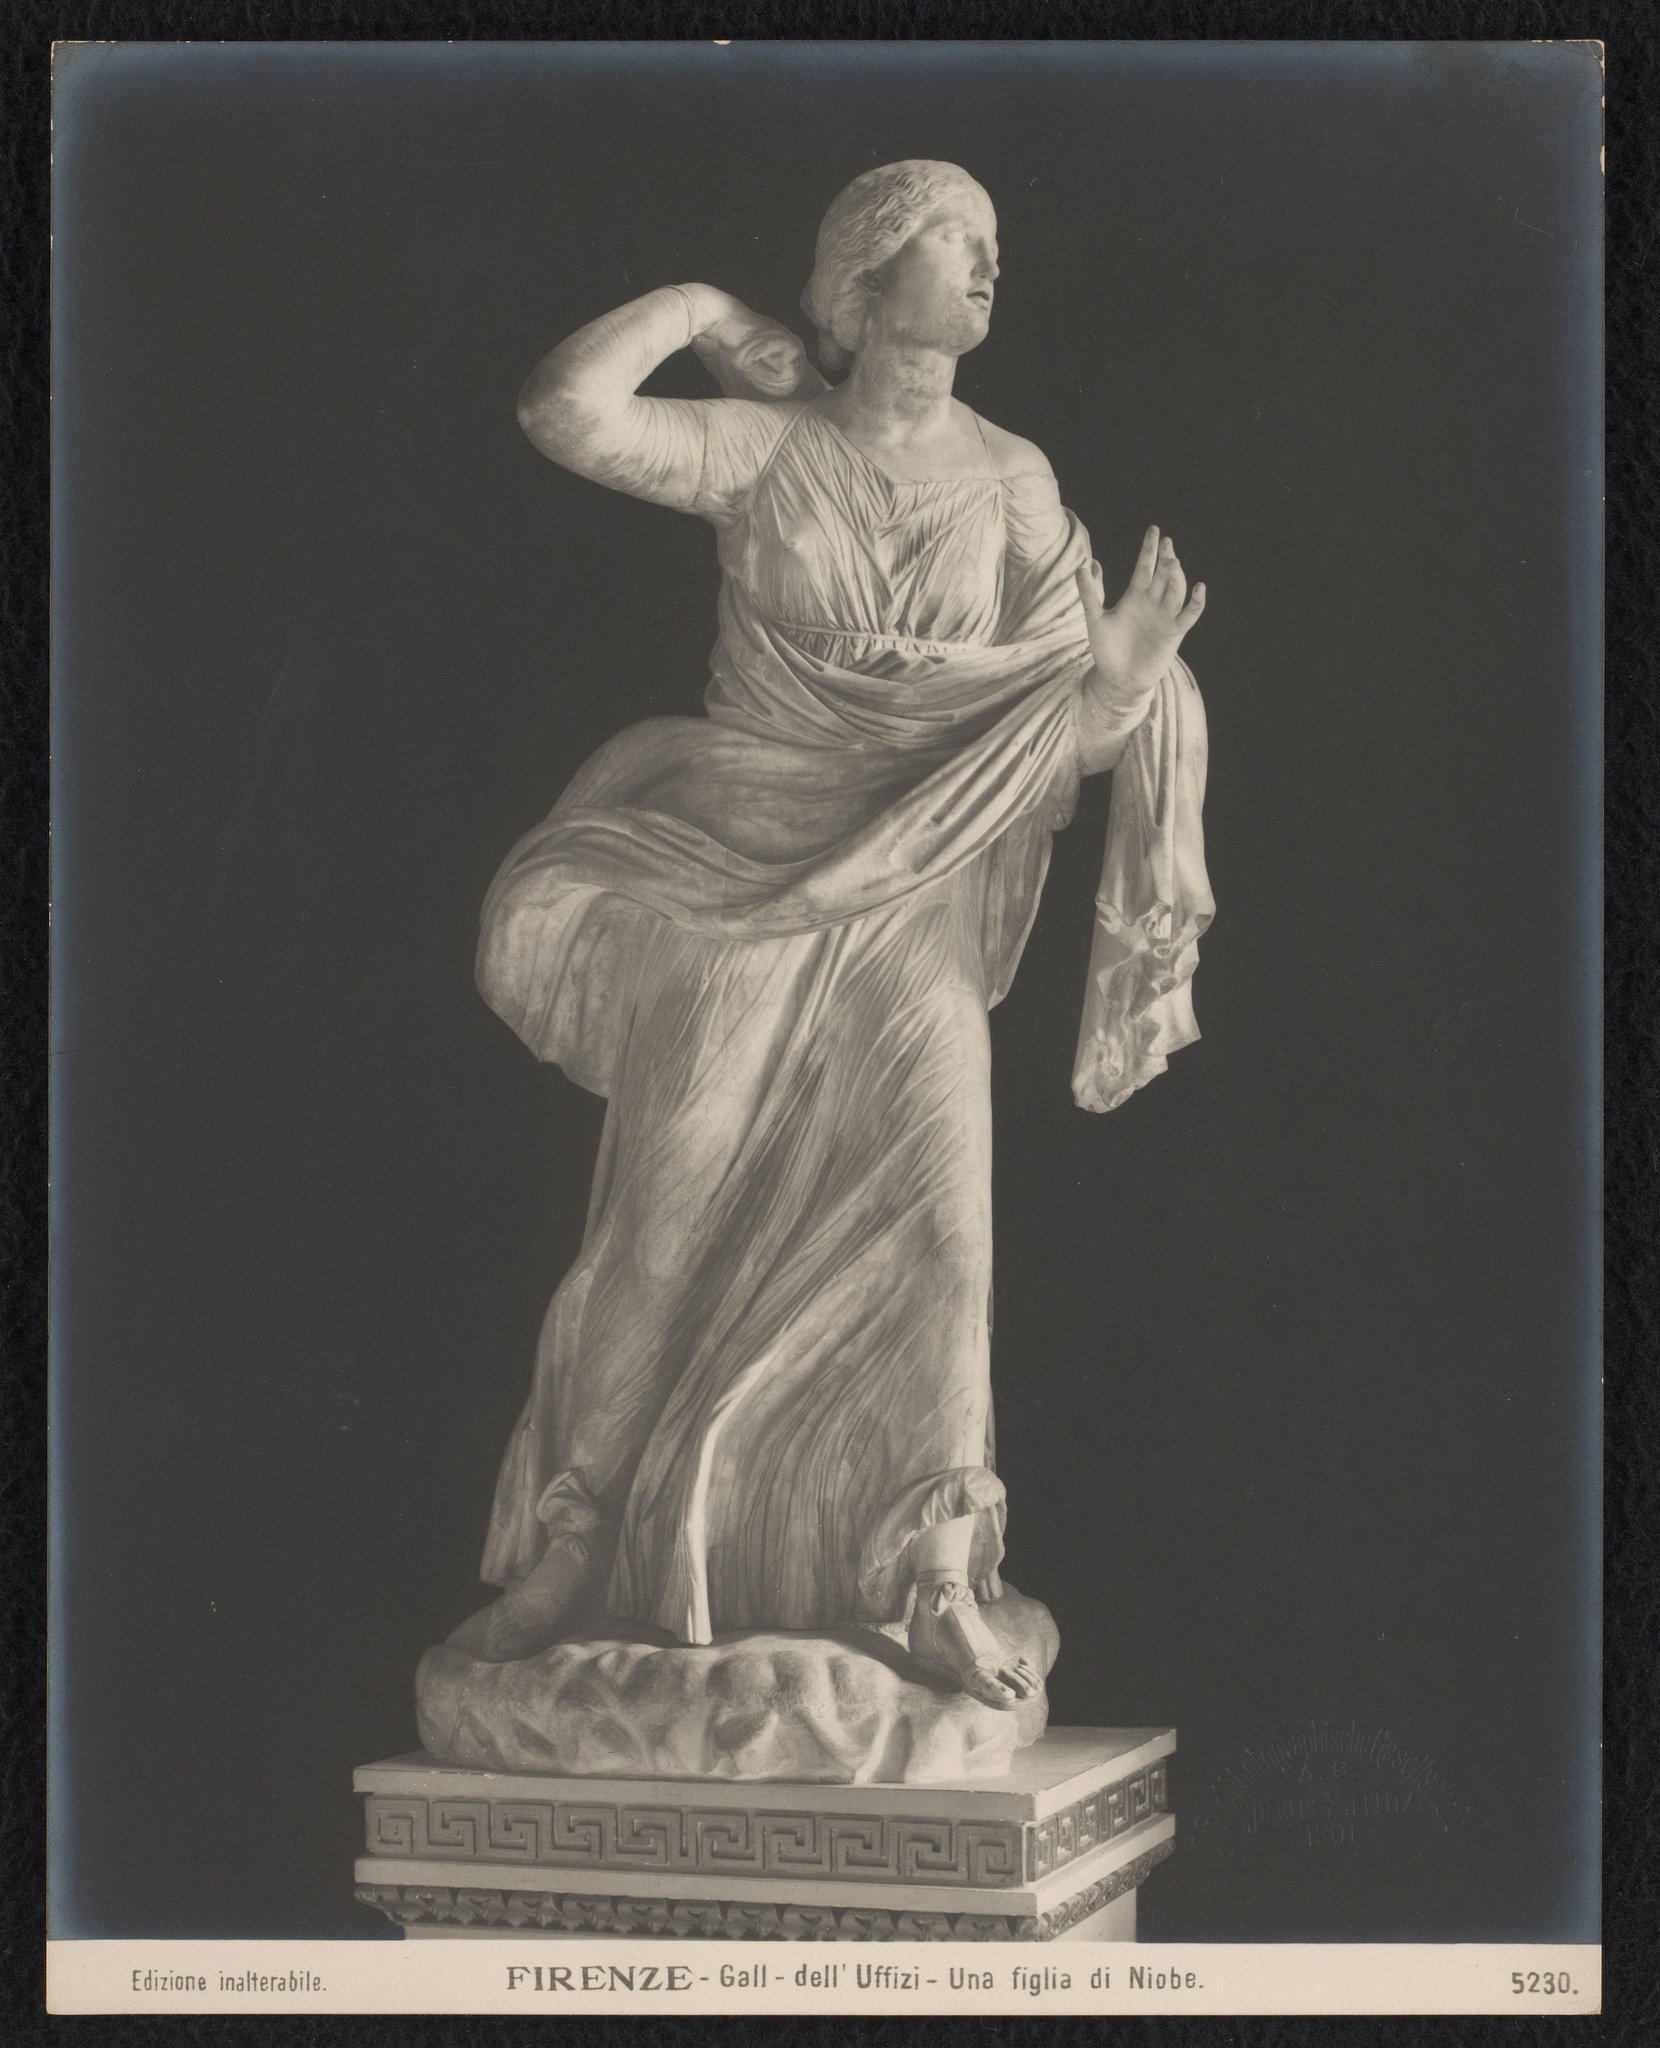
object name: photograph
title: Sculptuur van Niobe in de Galleria degli Uffizi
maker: Anonymous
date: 1901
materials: paper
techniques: gelatin silver print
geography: berlin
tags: (story of) bacchus (dionysus), liber, piece of sculpture, reproduction of a piece of sculpture, (story of) niobe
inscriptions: number: ‘5230.’, collector's mark: ‘RIJKS SCHOOL VOOR KUNSTNIJVERHEID/ GROEP’, inscription: ‘Edizione inalterabile.’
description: Deze foto maakt deel uit van een omslag.